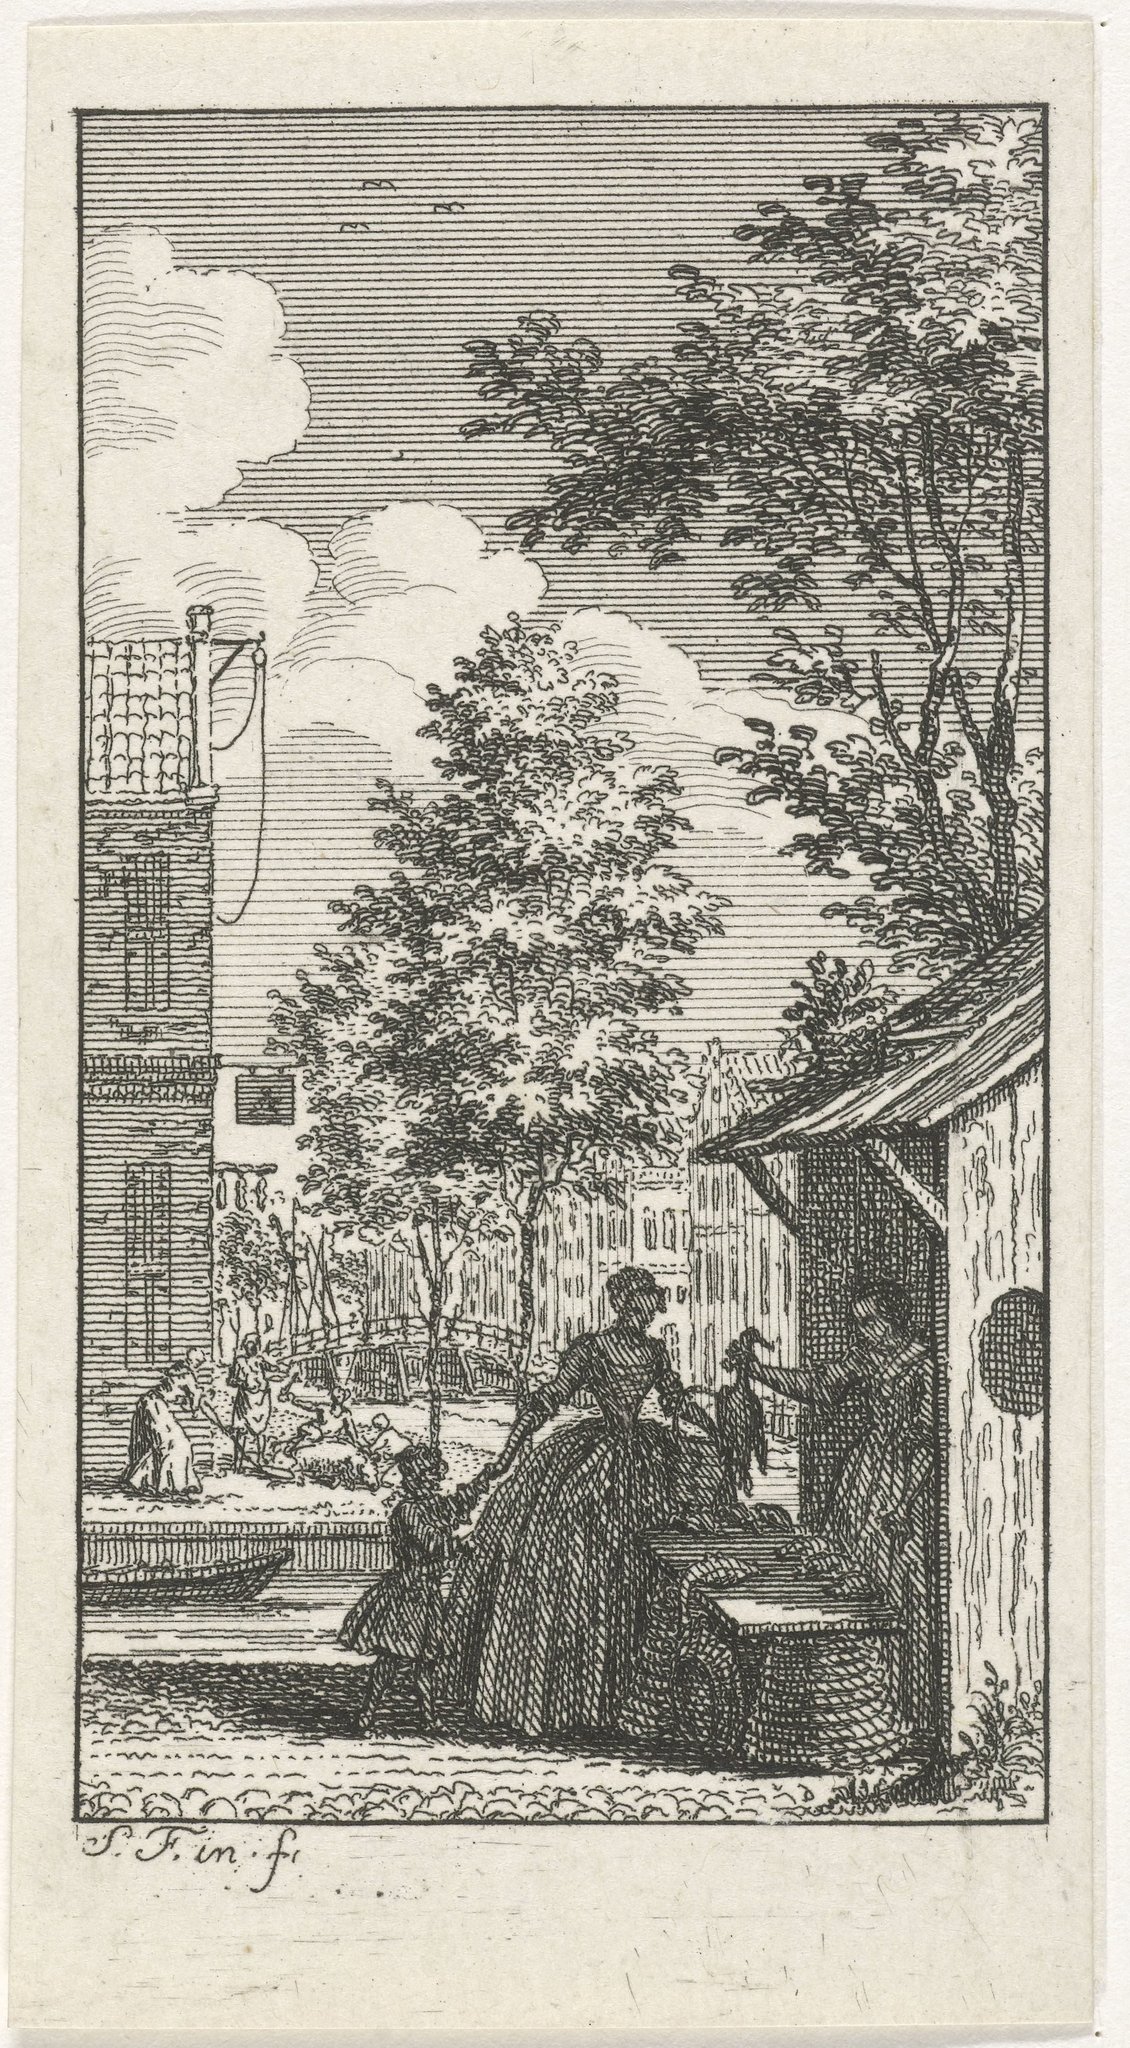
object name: print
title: De twaalf maanden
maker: simon fokke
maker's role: draughtsman, print maker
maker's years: 1712-1784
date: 1722-1784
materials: paper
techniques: etching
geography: amsterdam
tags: november ~ other concepts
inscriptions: collector's mark: Lugt 240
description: Uit een serie van twaalf prenten, de verbeelding van de maand november. Een vrouw met kind staat bij een kraam waar gevogelte en vis verkocht wordt.